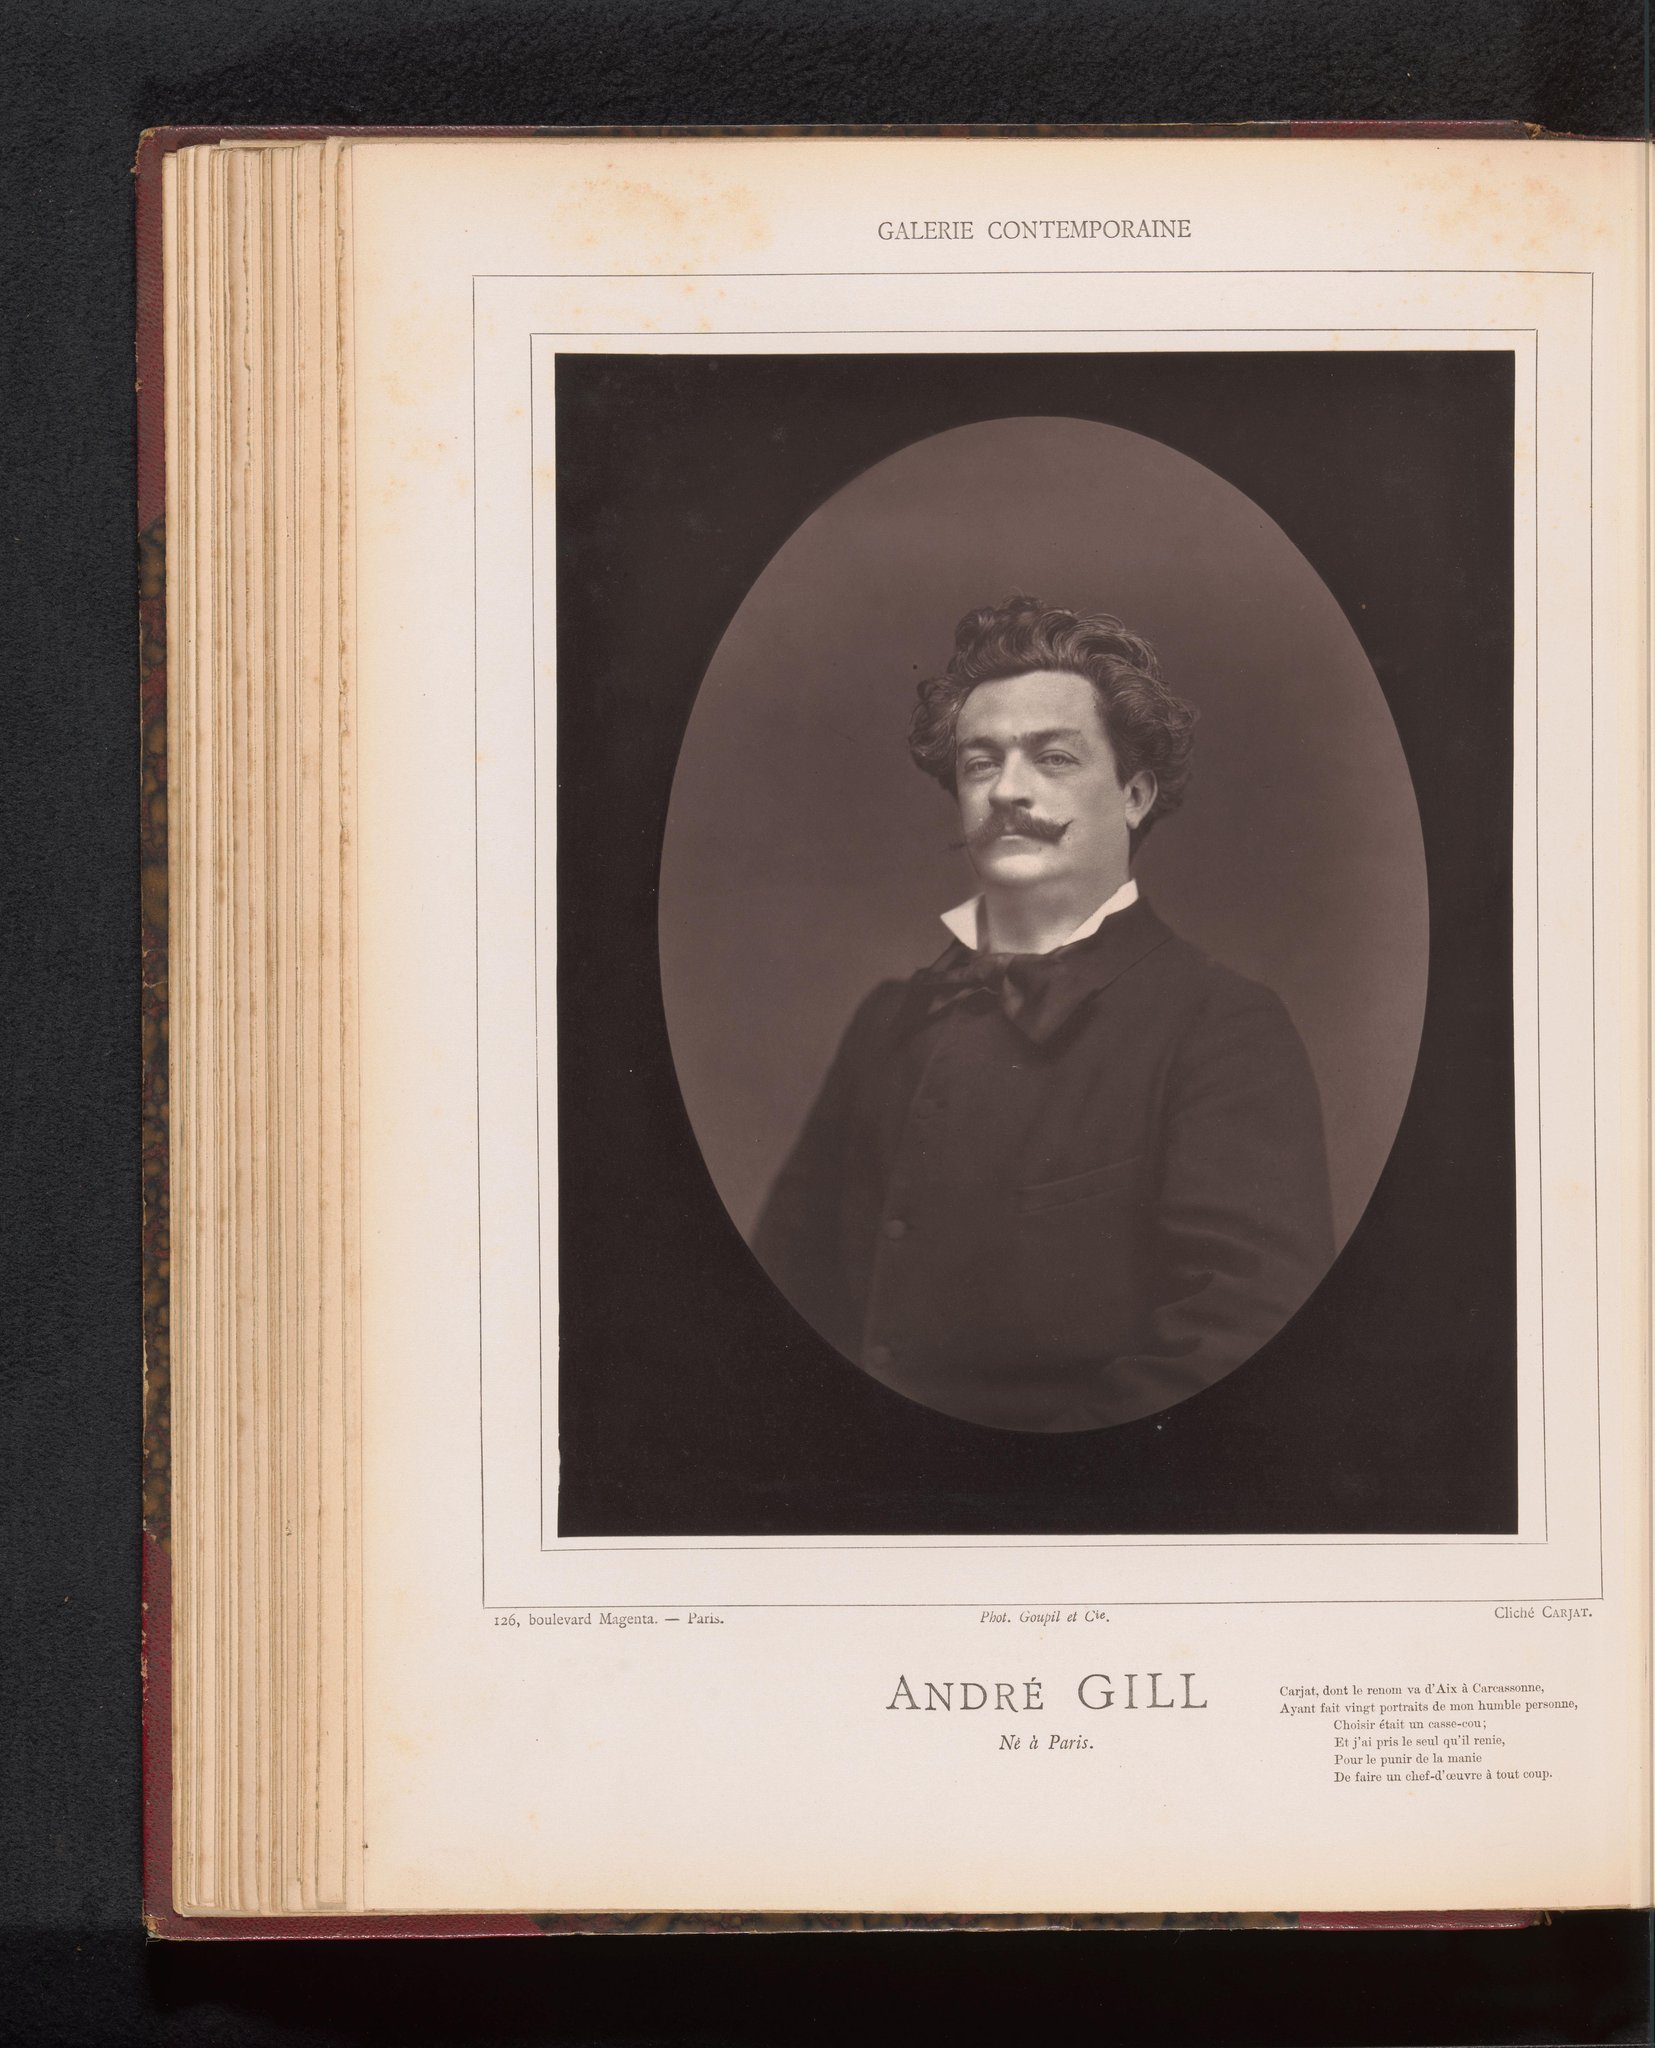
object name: page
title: André Gill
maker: étienne carjat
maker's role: draughtsman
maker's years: 1828-1906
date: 1873-1878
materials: paper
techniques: woodburytype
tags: painter, andré gill, adult man, historical persons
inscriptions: inscription: ‘Galerie Contemporaine/ 126, boulevard Magenta. - Paris./ Né à Paris./ Carjat, dont le renom va d'Aix a Carcassonne, (...)’